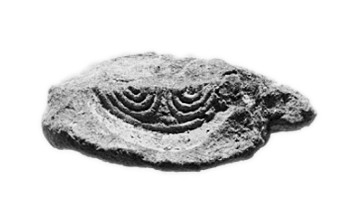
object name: sealing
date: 1981-1640 BCE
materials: mud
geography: egypt